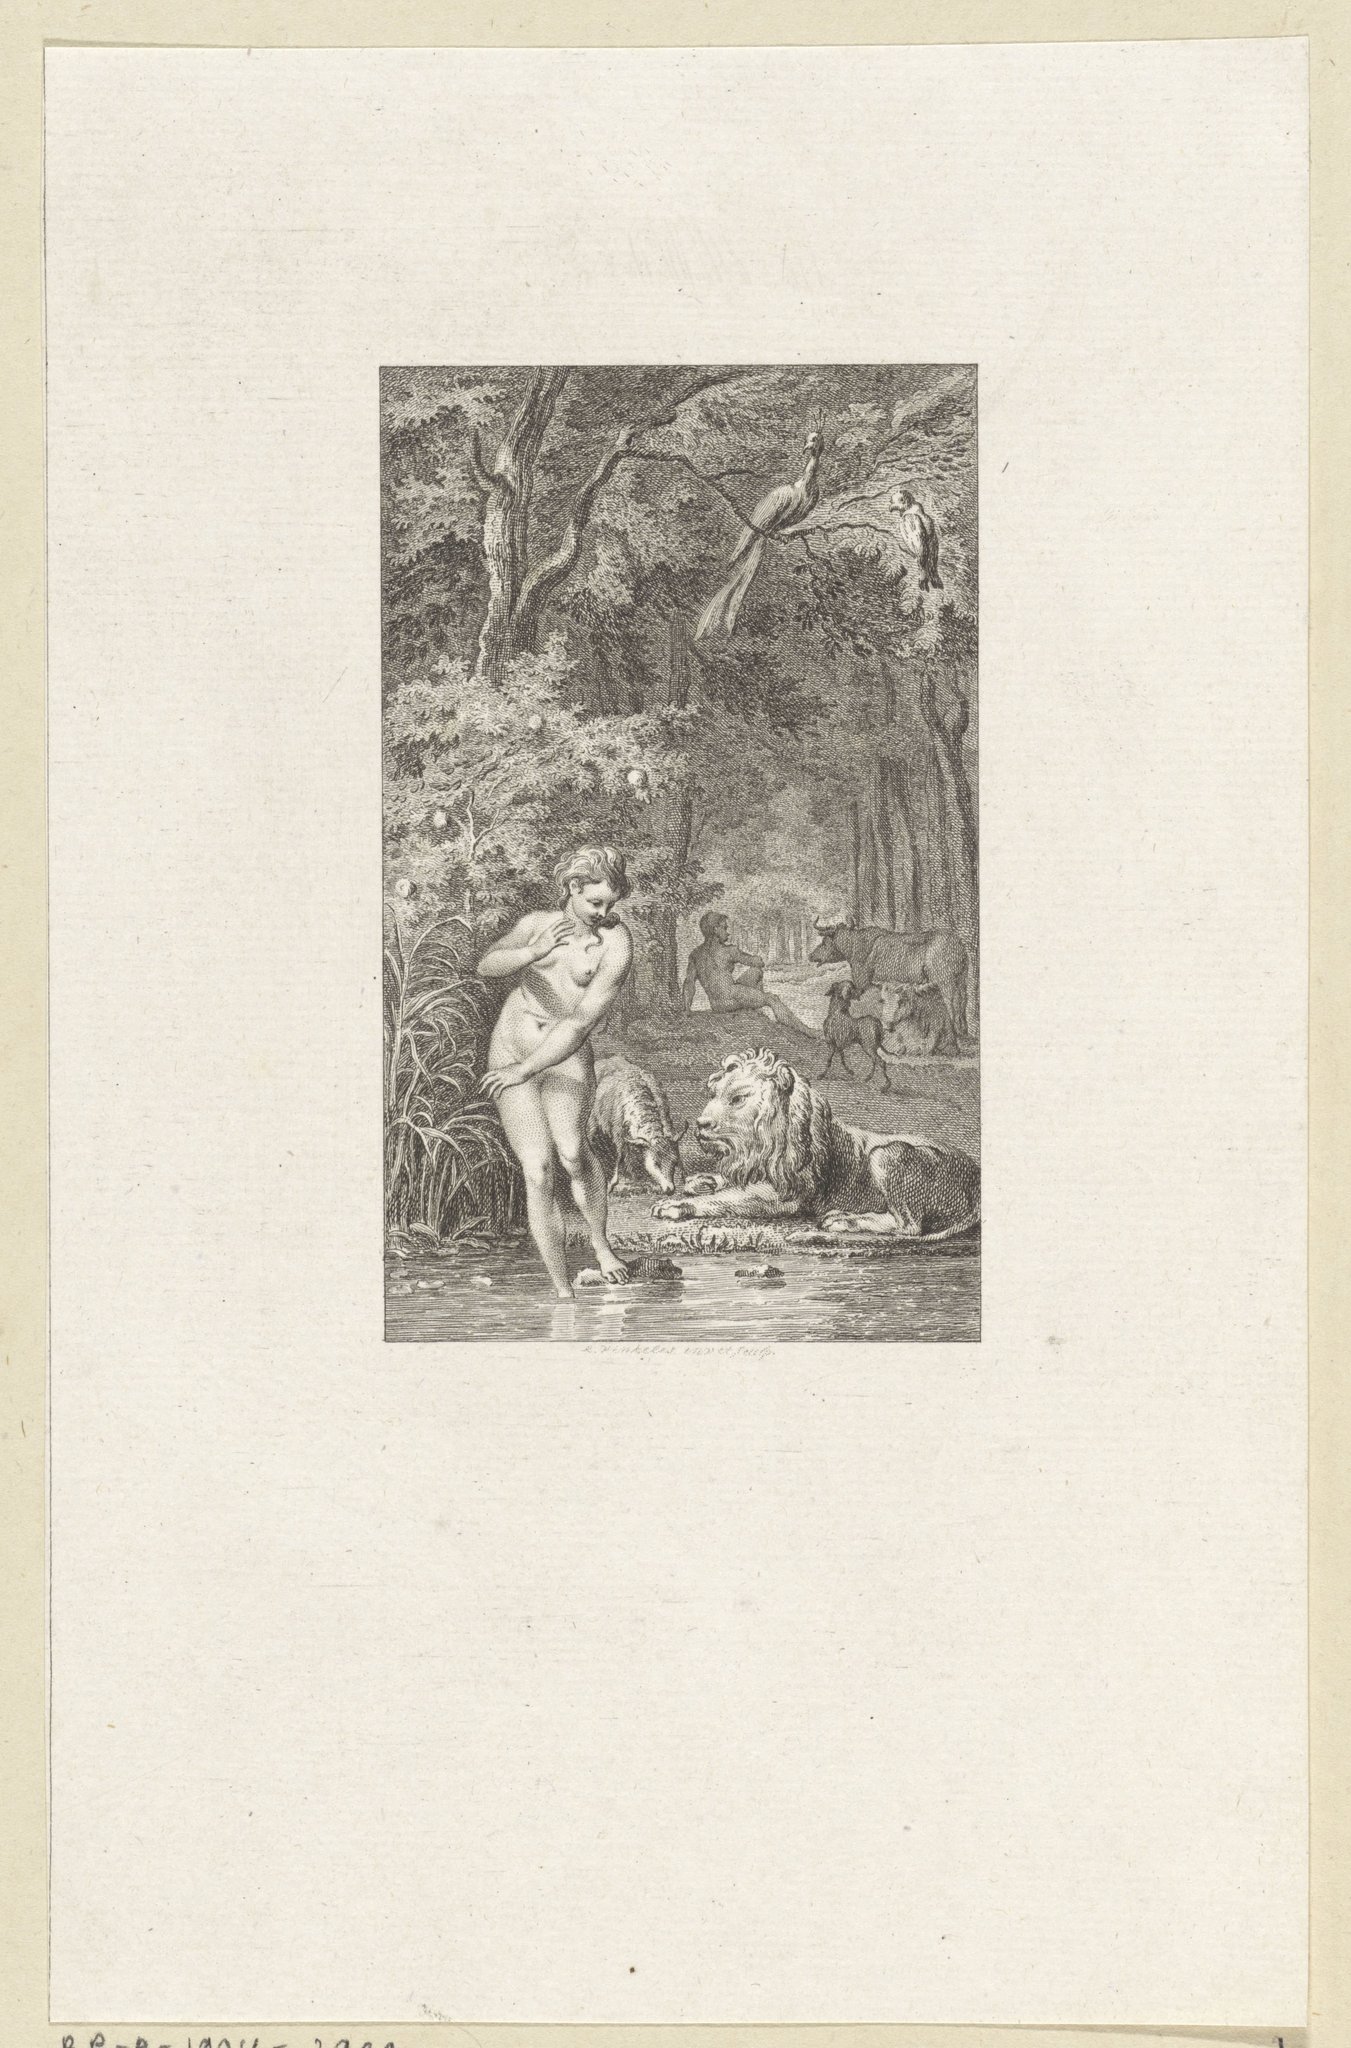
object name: print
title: Jonge vrouw loopt het water in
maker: reinier vinkeles (i)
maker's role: draughtsman, print maker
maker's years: 1741-1816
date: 1785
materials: paper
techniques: engraving, etching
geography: amsterdam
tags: lake, forest, wood, taking a bath - aa - in the open air, night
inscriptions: collector's mark: Lugt 2228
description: Een jonge vrouw staat tot haar enkels in een meertje en lijkt een bad te gaan nemen. Aan de waterkant liggen een leeuw en een lam. Op de achtergrond een man, een hond en twee runderen.